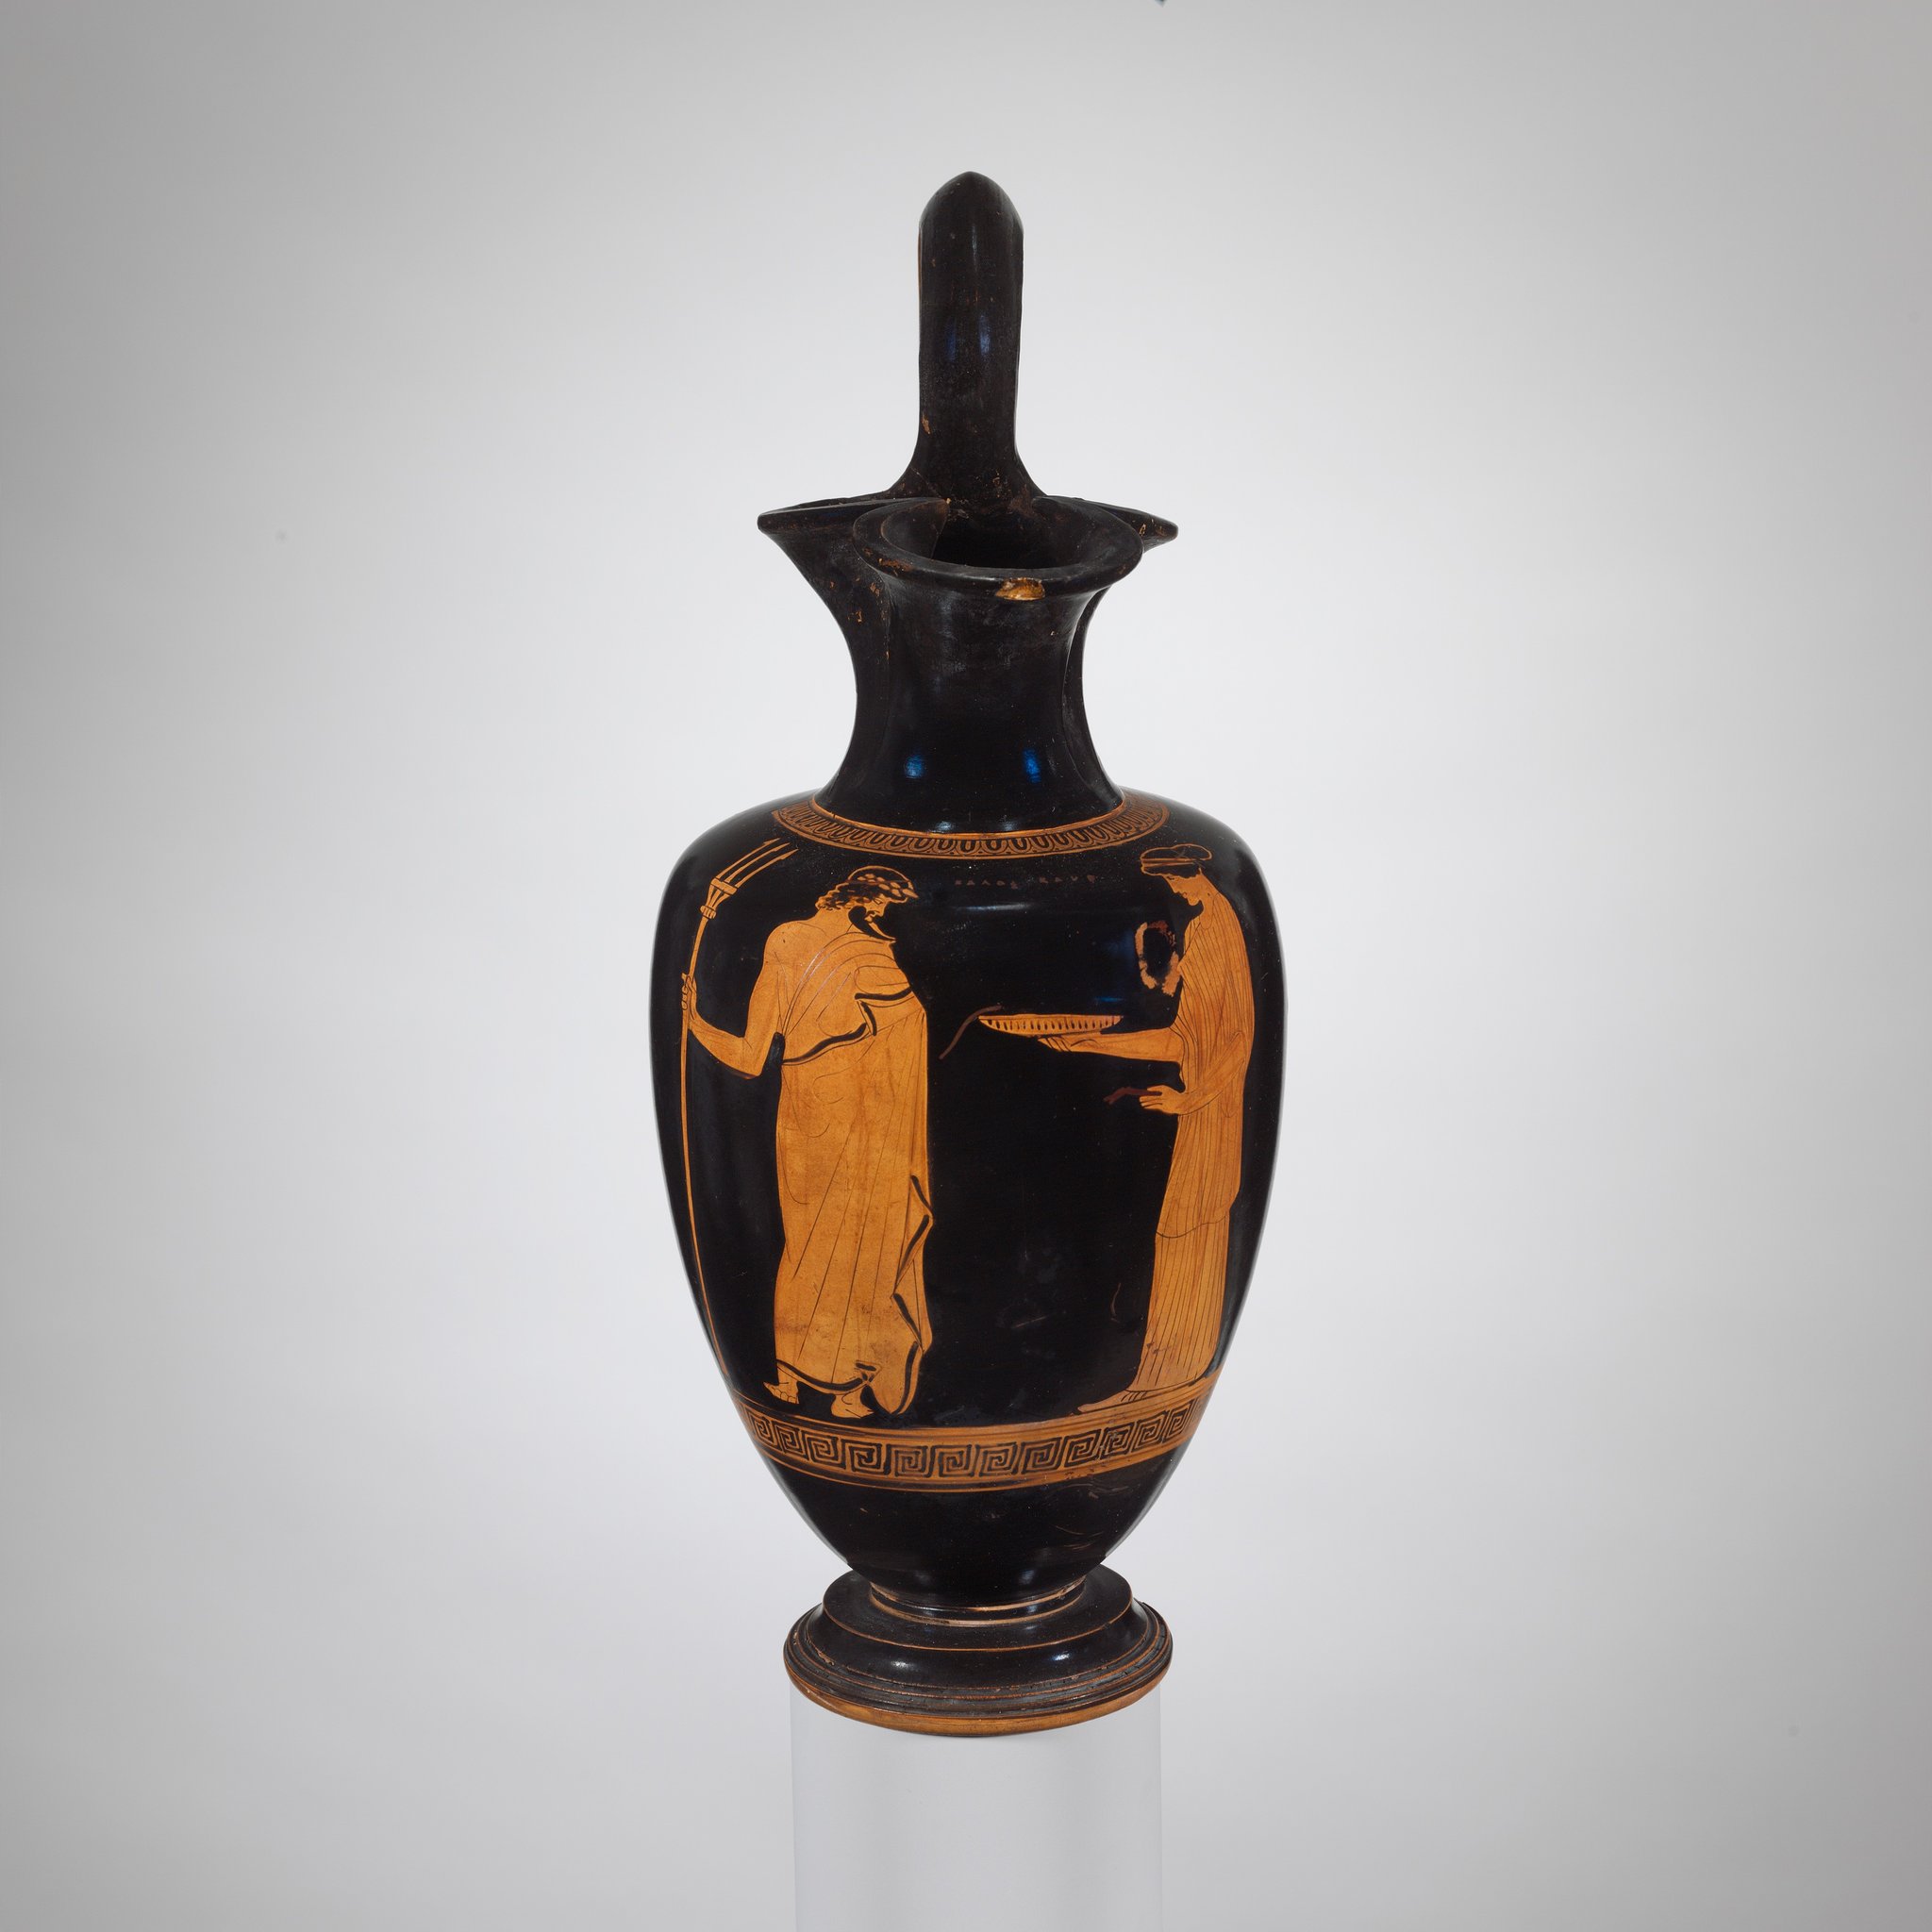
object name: oinochoe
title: Terracotta oinochoe (jug)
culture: greek, attic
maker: richmond painter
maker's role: artist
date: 450-425 BCE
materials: terracotta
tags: women,poseidon